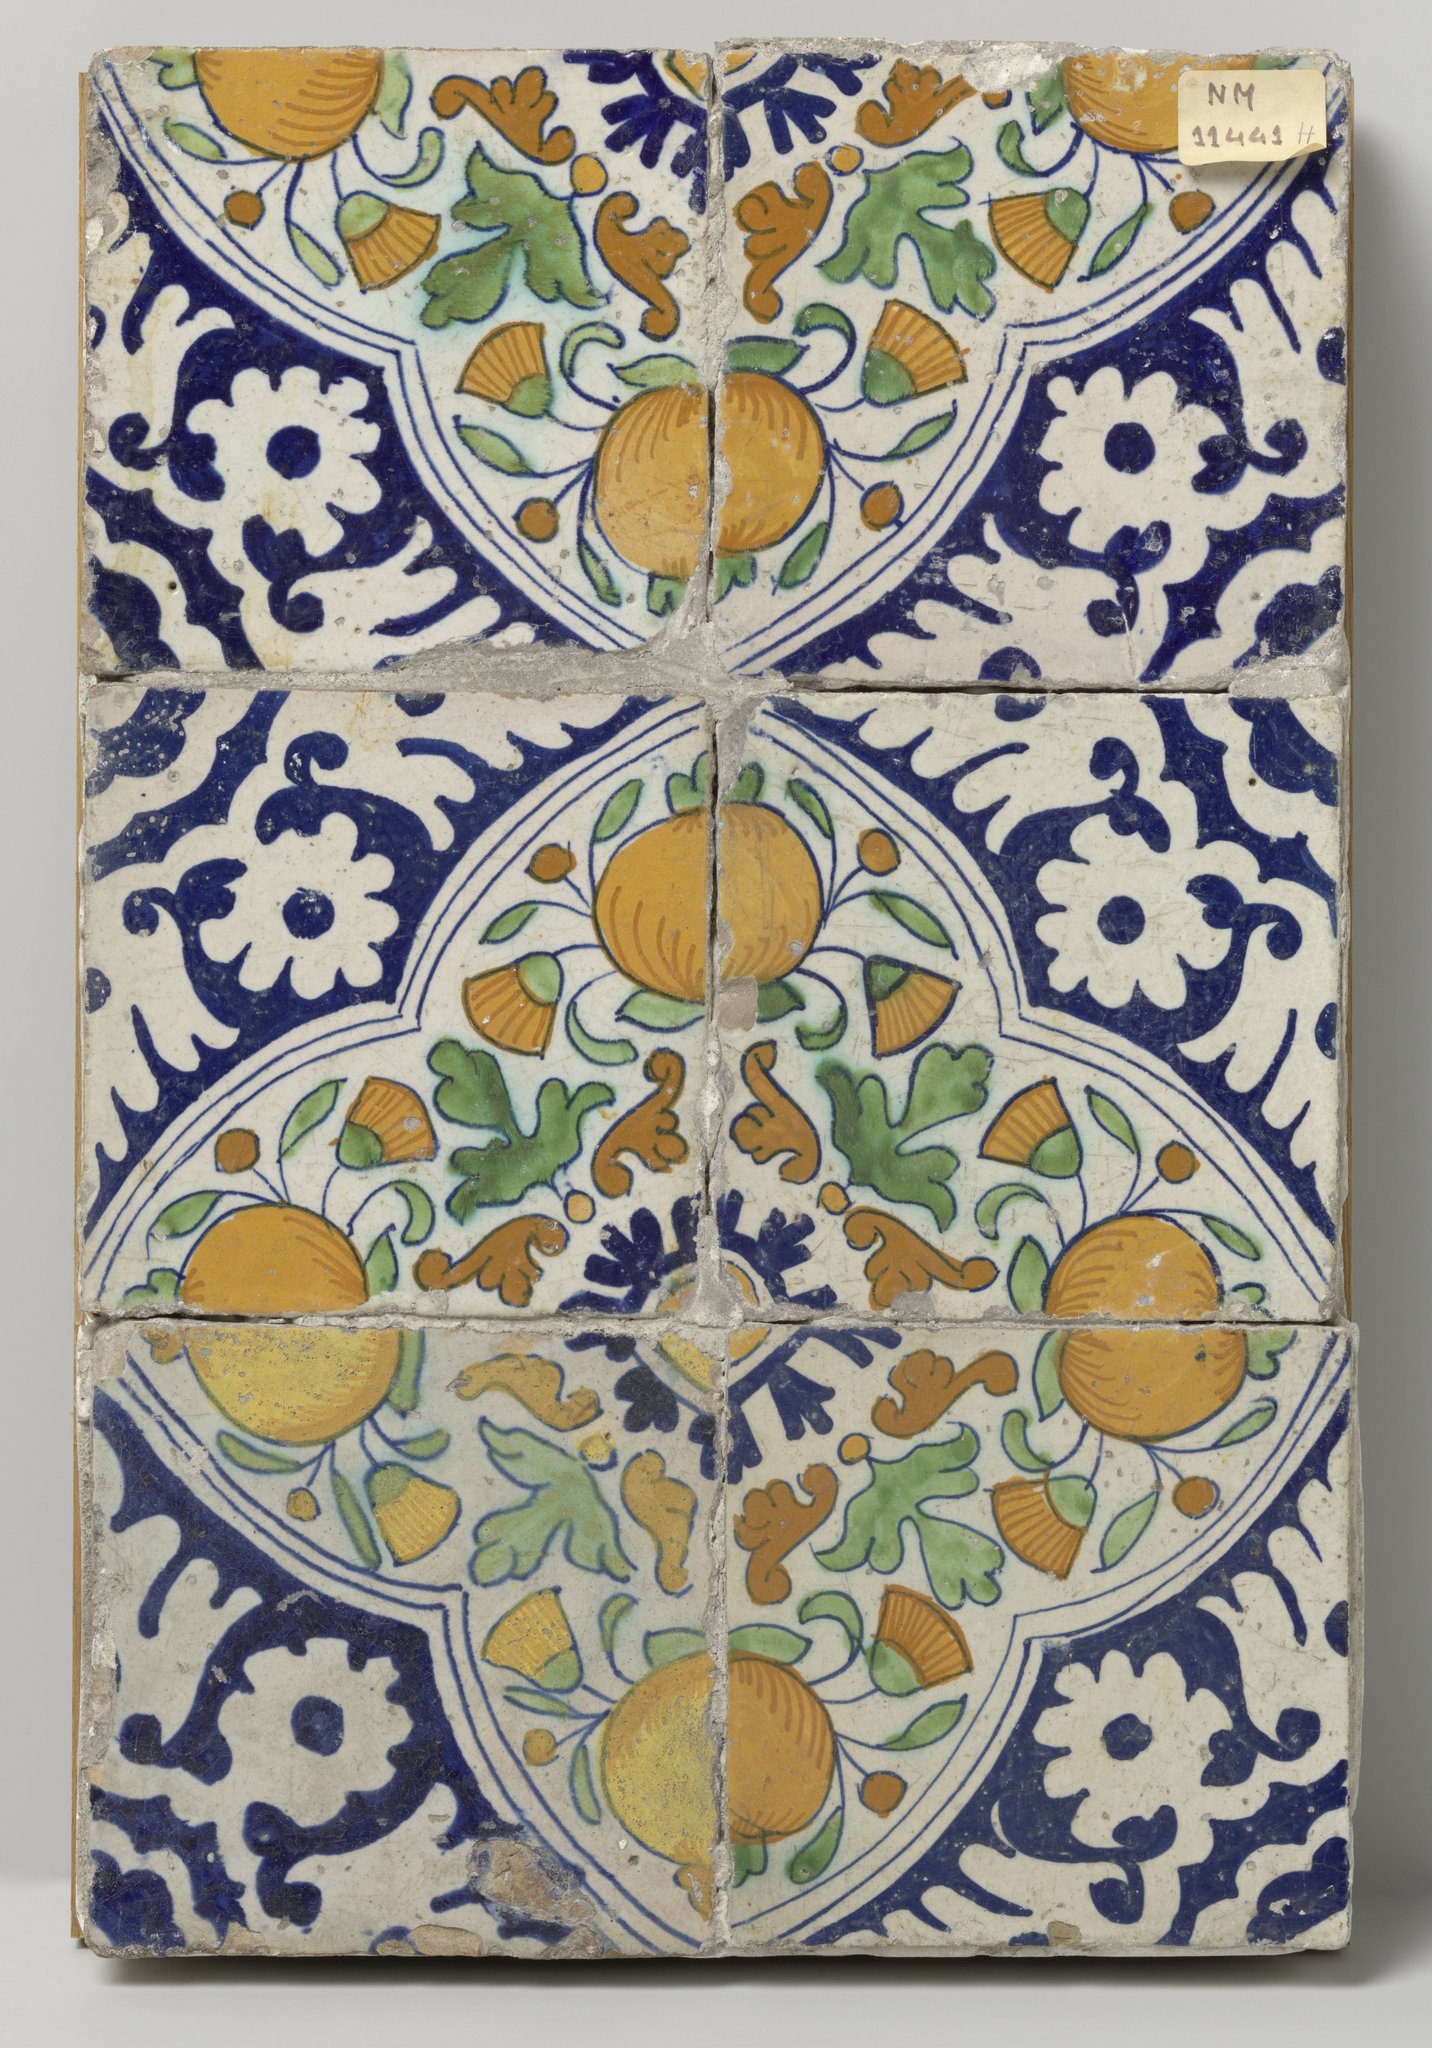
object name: tile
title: 6 Vierpastegels in tegelveld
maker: Anonymous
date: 1580-1620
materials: earthenware, glaze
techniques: maiolica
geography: netherlands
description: 6 vierpastegels geplaatst in tegelveld van 3 x 2. Vier tegels vormen samen een vierpas met rozet omgeven door granaatappels en goudsbloemen. In de hoeken, ornament in vultechniek.